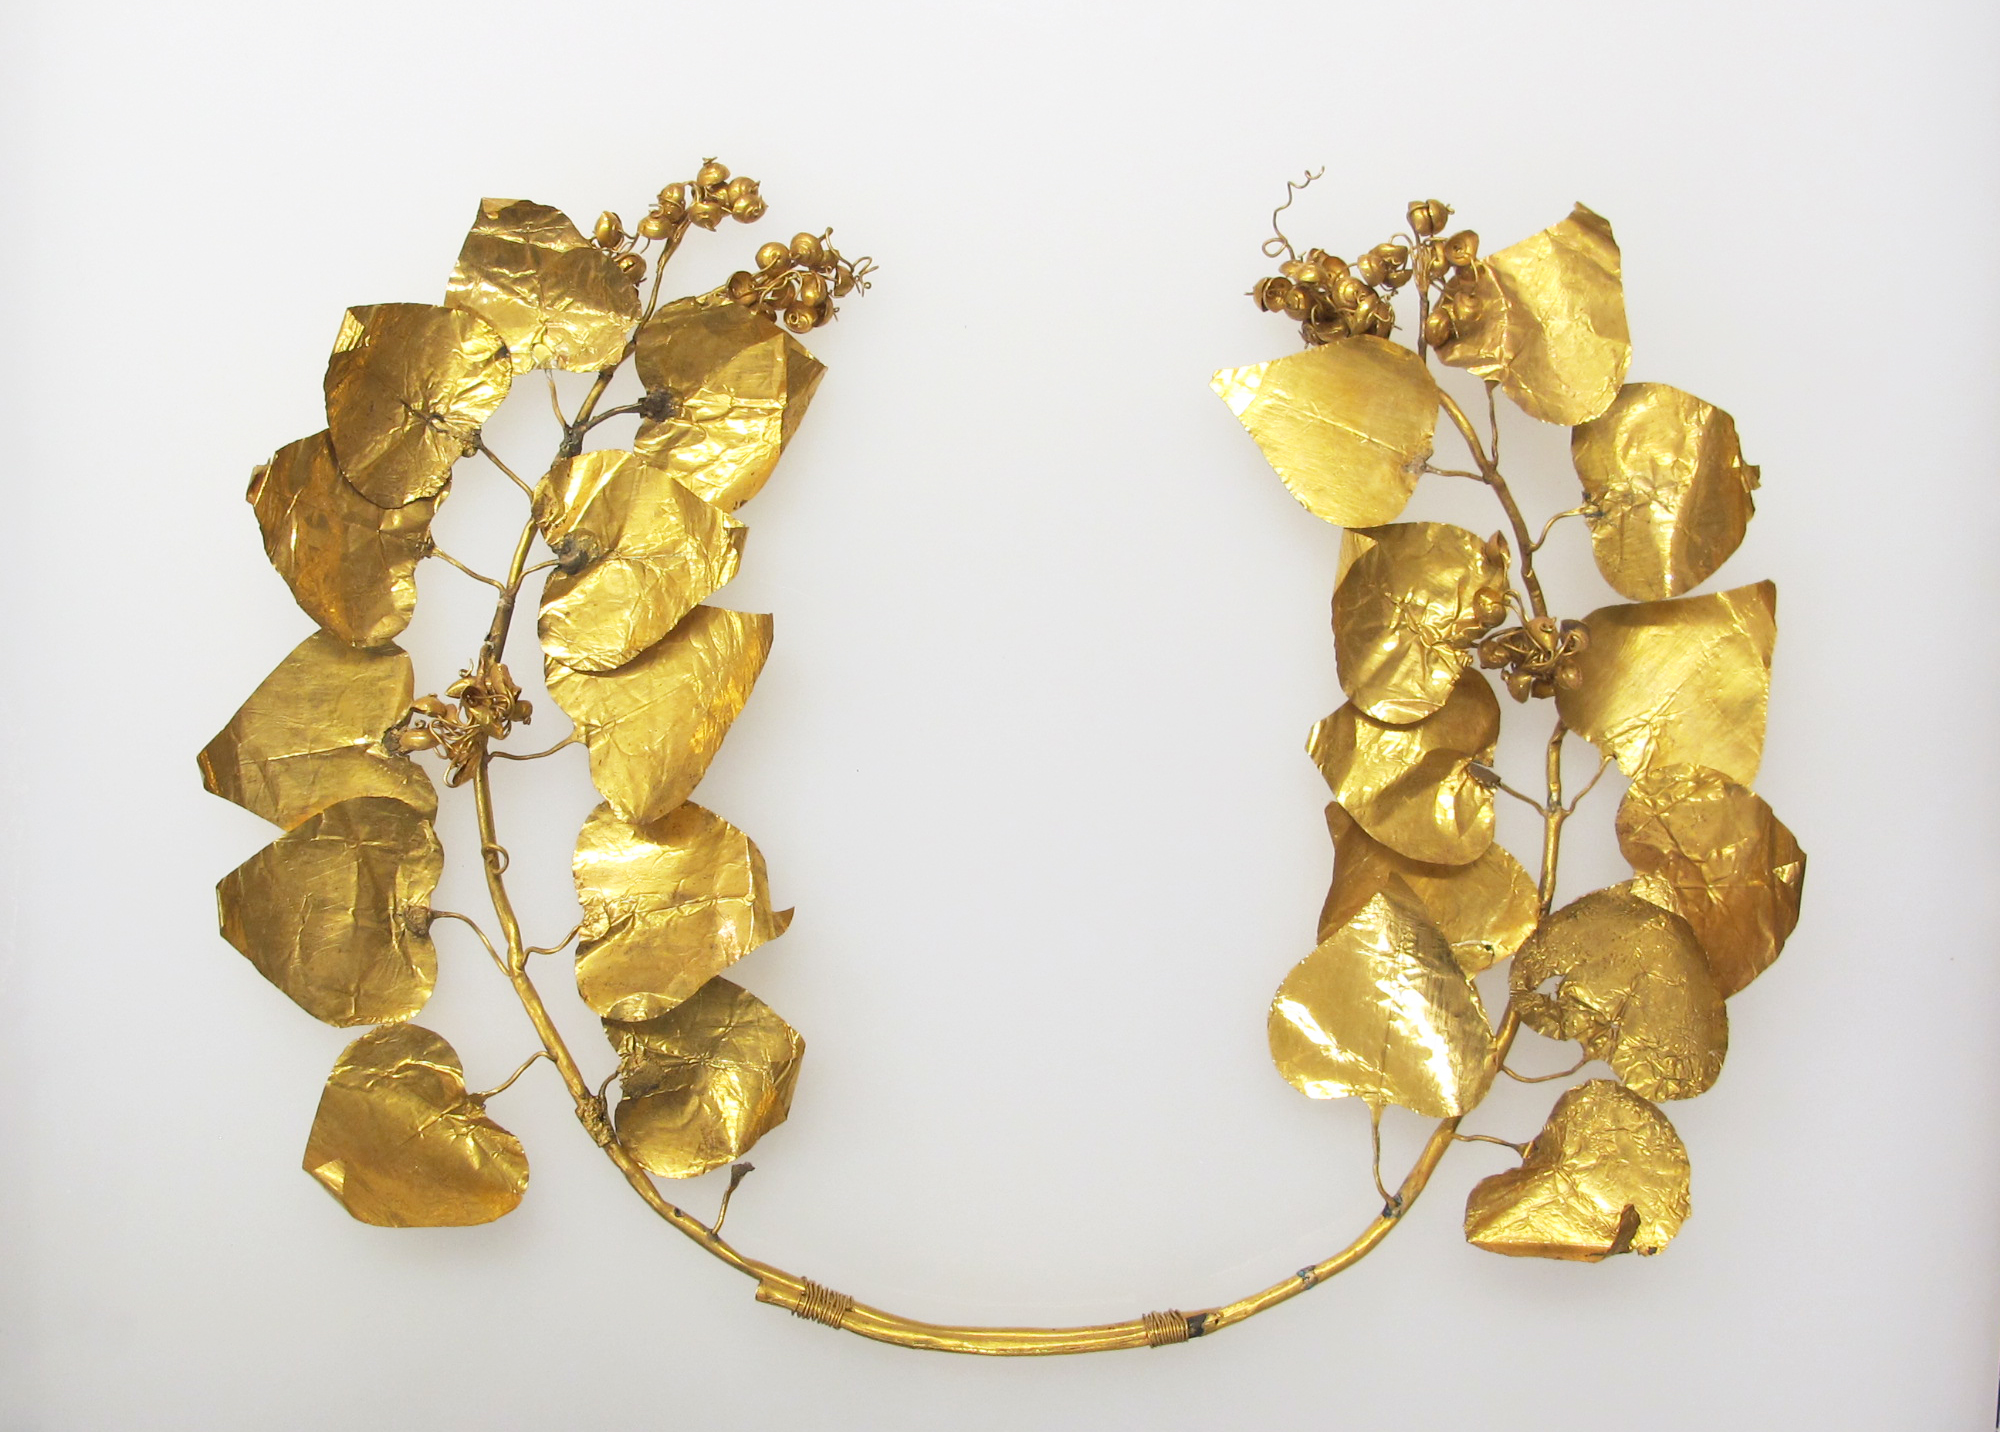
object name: wreath of ivy and berry, funerary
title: Wreath of ivy and berries, funerary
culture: greek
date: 400-201 BCE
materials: gold